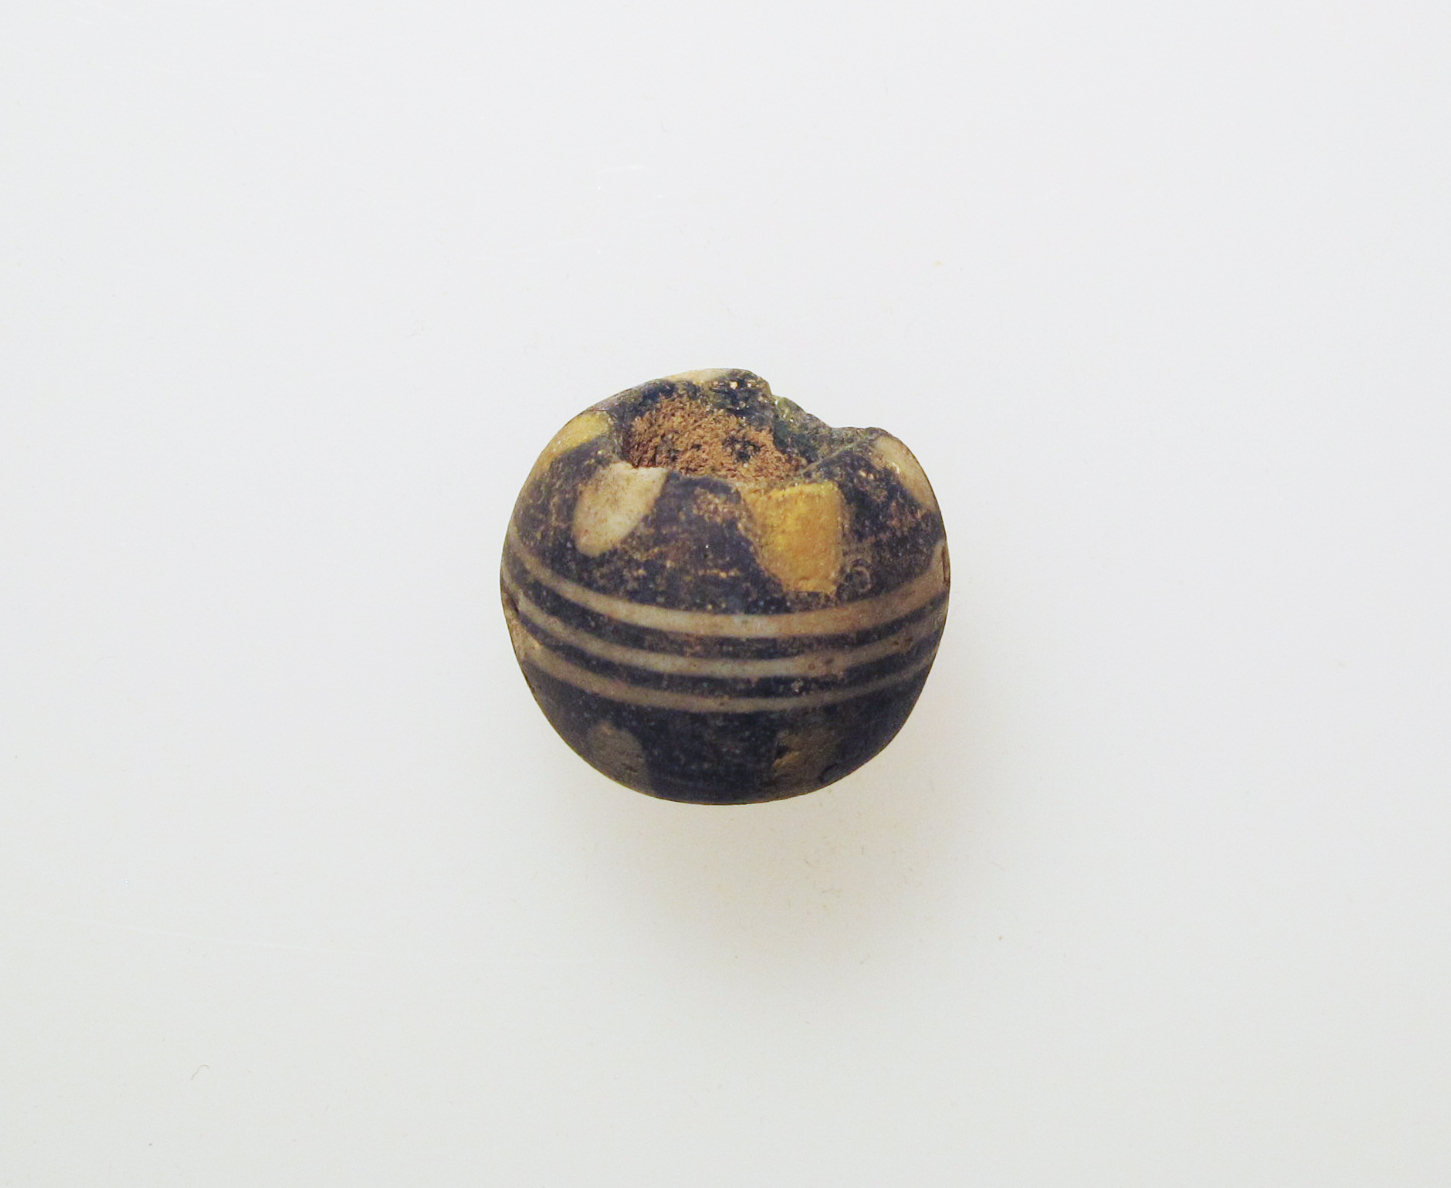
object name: bead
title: Glass bead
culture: carthaginian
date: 367-335 BCE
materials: glass